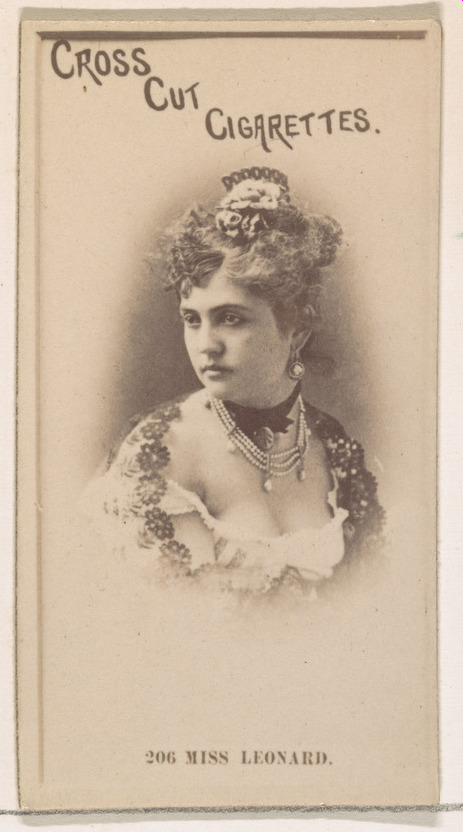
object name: print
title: Card Number 206, Miss Leonard, from the Actors and Actresses series (N145-2) issued by Duke Sons & Co. to promote Cross Cut Cigarettes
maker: w. duke, sons & co.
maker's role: publisher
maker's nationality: american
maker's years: 1870-1920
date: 1880-1889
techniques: albumen silver print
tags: portraits,women,actresses